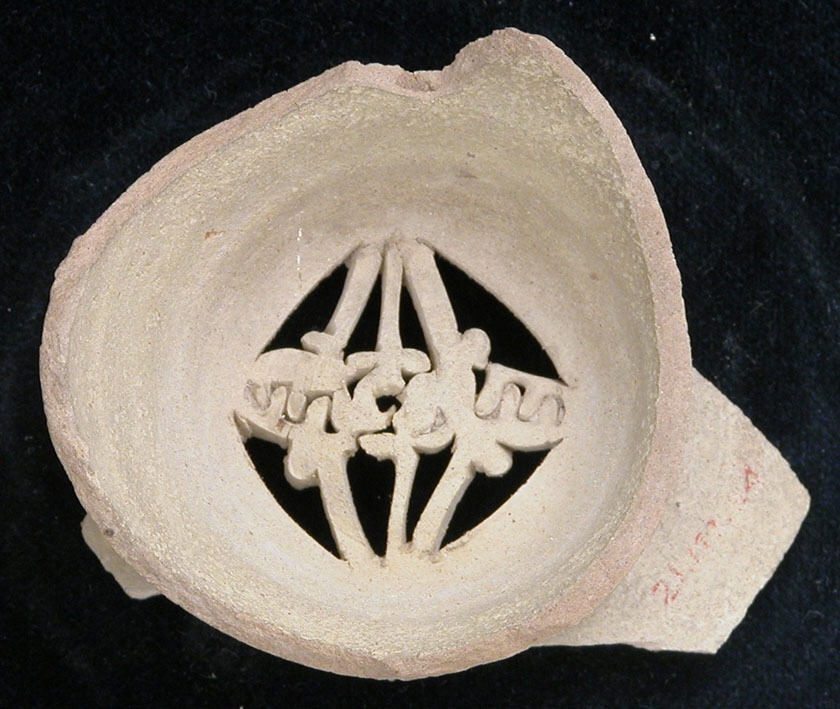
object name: water filter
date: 901-1200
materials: earthenware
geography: egypt